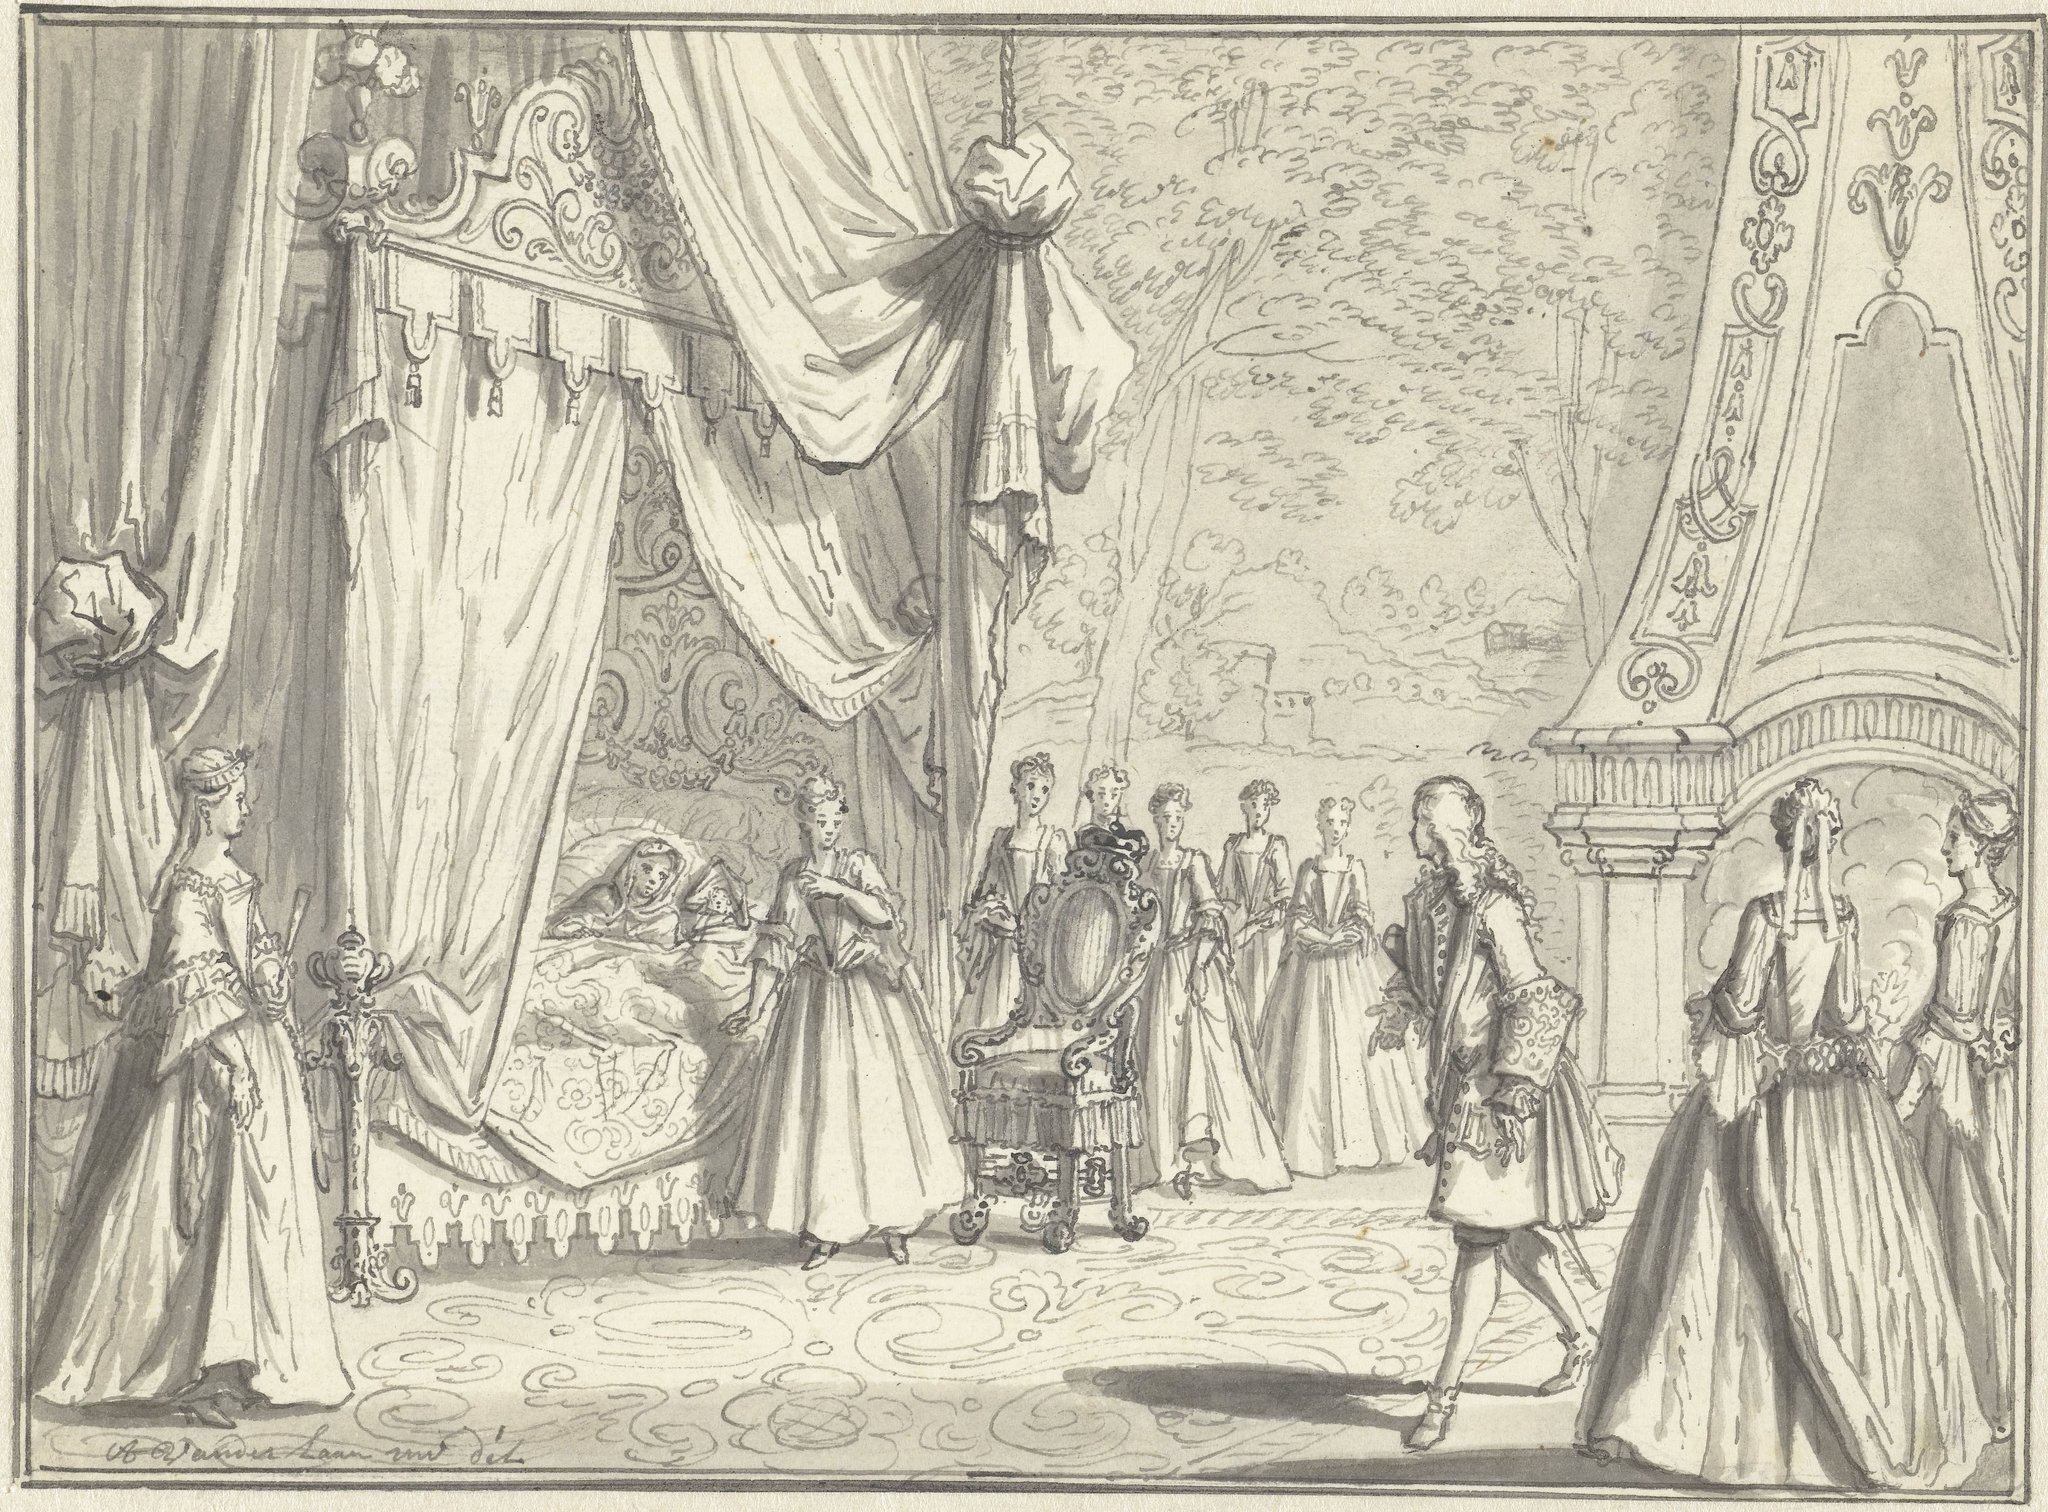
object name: drawing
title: De prinses van Wales, bevallen van haar dochter Louise, 1724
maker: adolf van der laan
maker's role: draughtsman, print maker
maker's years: 1689-1742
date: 1724-1727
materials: ink, paper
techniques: brush, pen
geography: northern netherlands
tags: lying-in room, bedroom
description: De prinses van Wales, bevallen van haar dochter Louise, 18 december 1724. Ontwerp voor één van de negen voorstellingen in de prent met de gebeurtenissen in het jaar 1724.